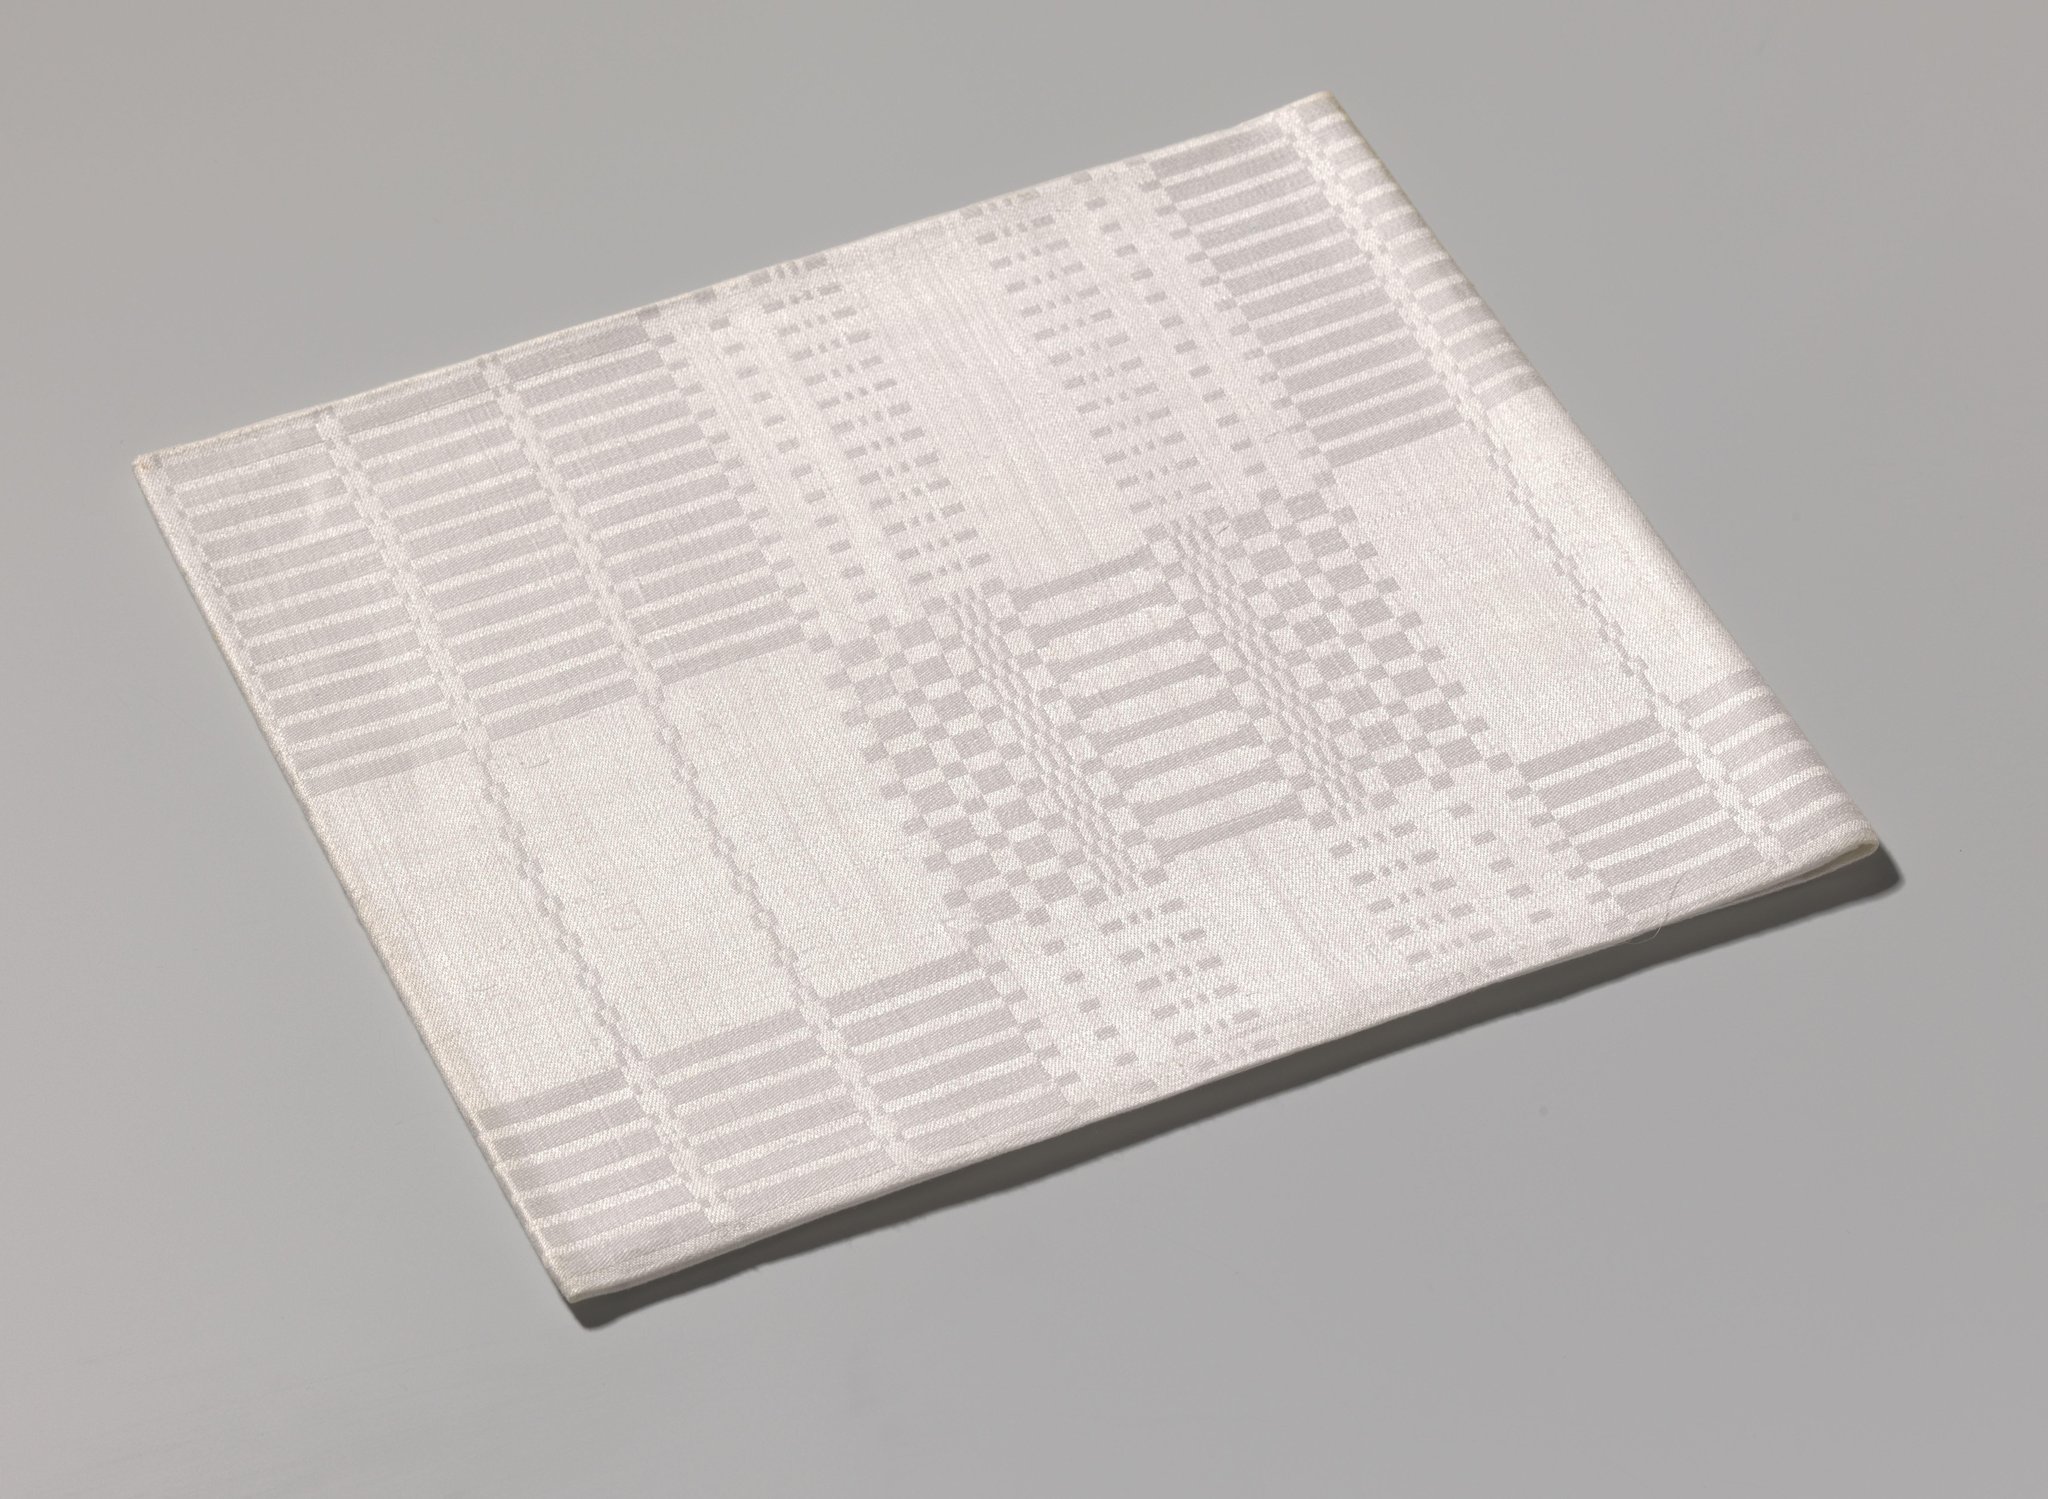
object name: napkin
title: Servet van linnen met pellenpatroon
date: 1790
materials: linen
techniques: peeled fabric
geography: northern netherlands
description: Wit linnendamasten servet met pellenpatroon, merk kroon SW 35 en 1790.